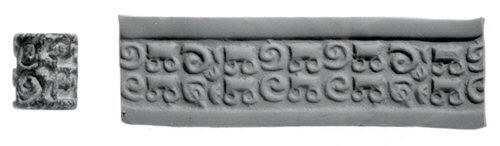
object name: cylinder seal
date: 3000-2668 BCE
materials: stone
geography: syria